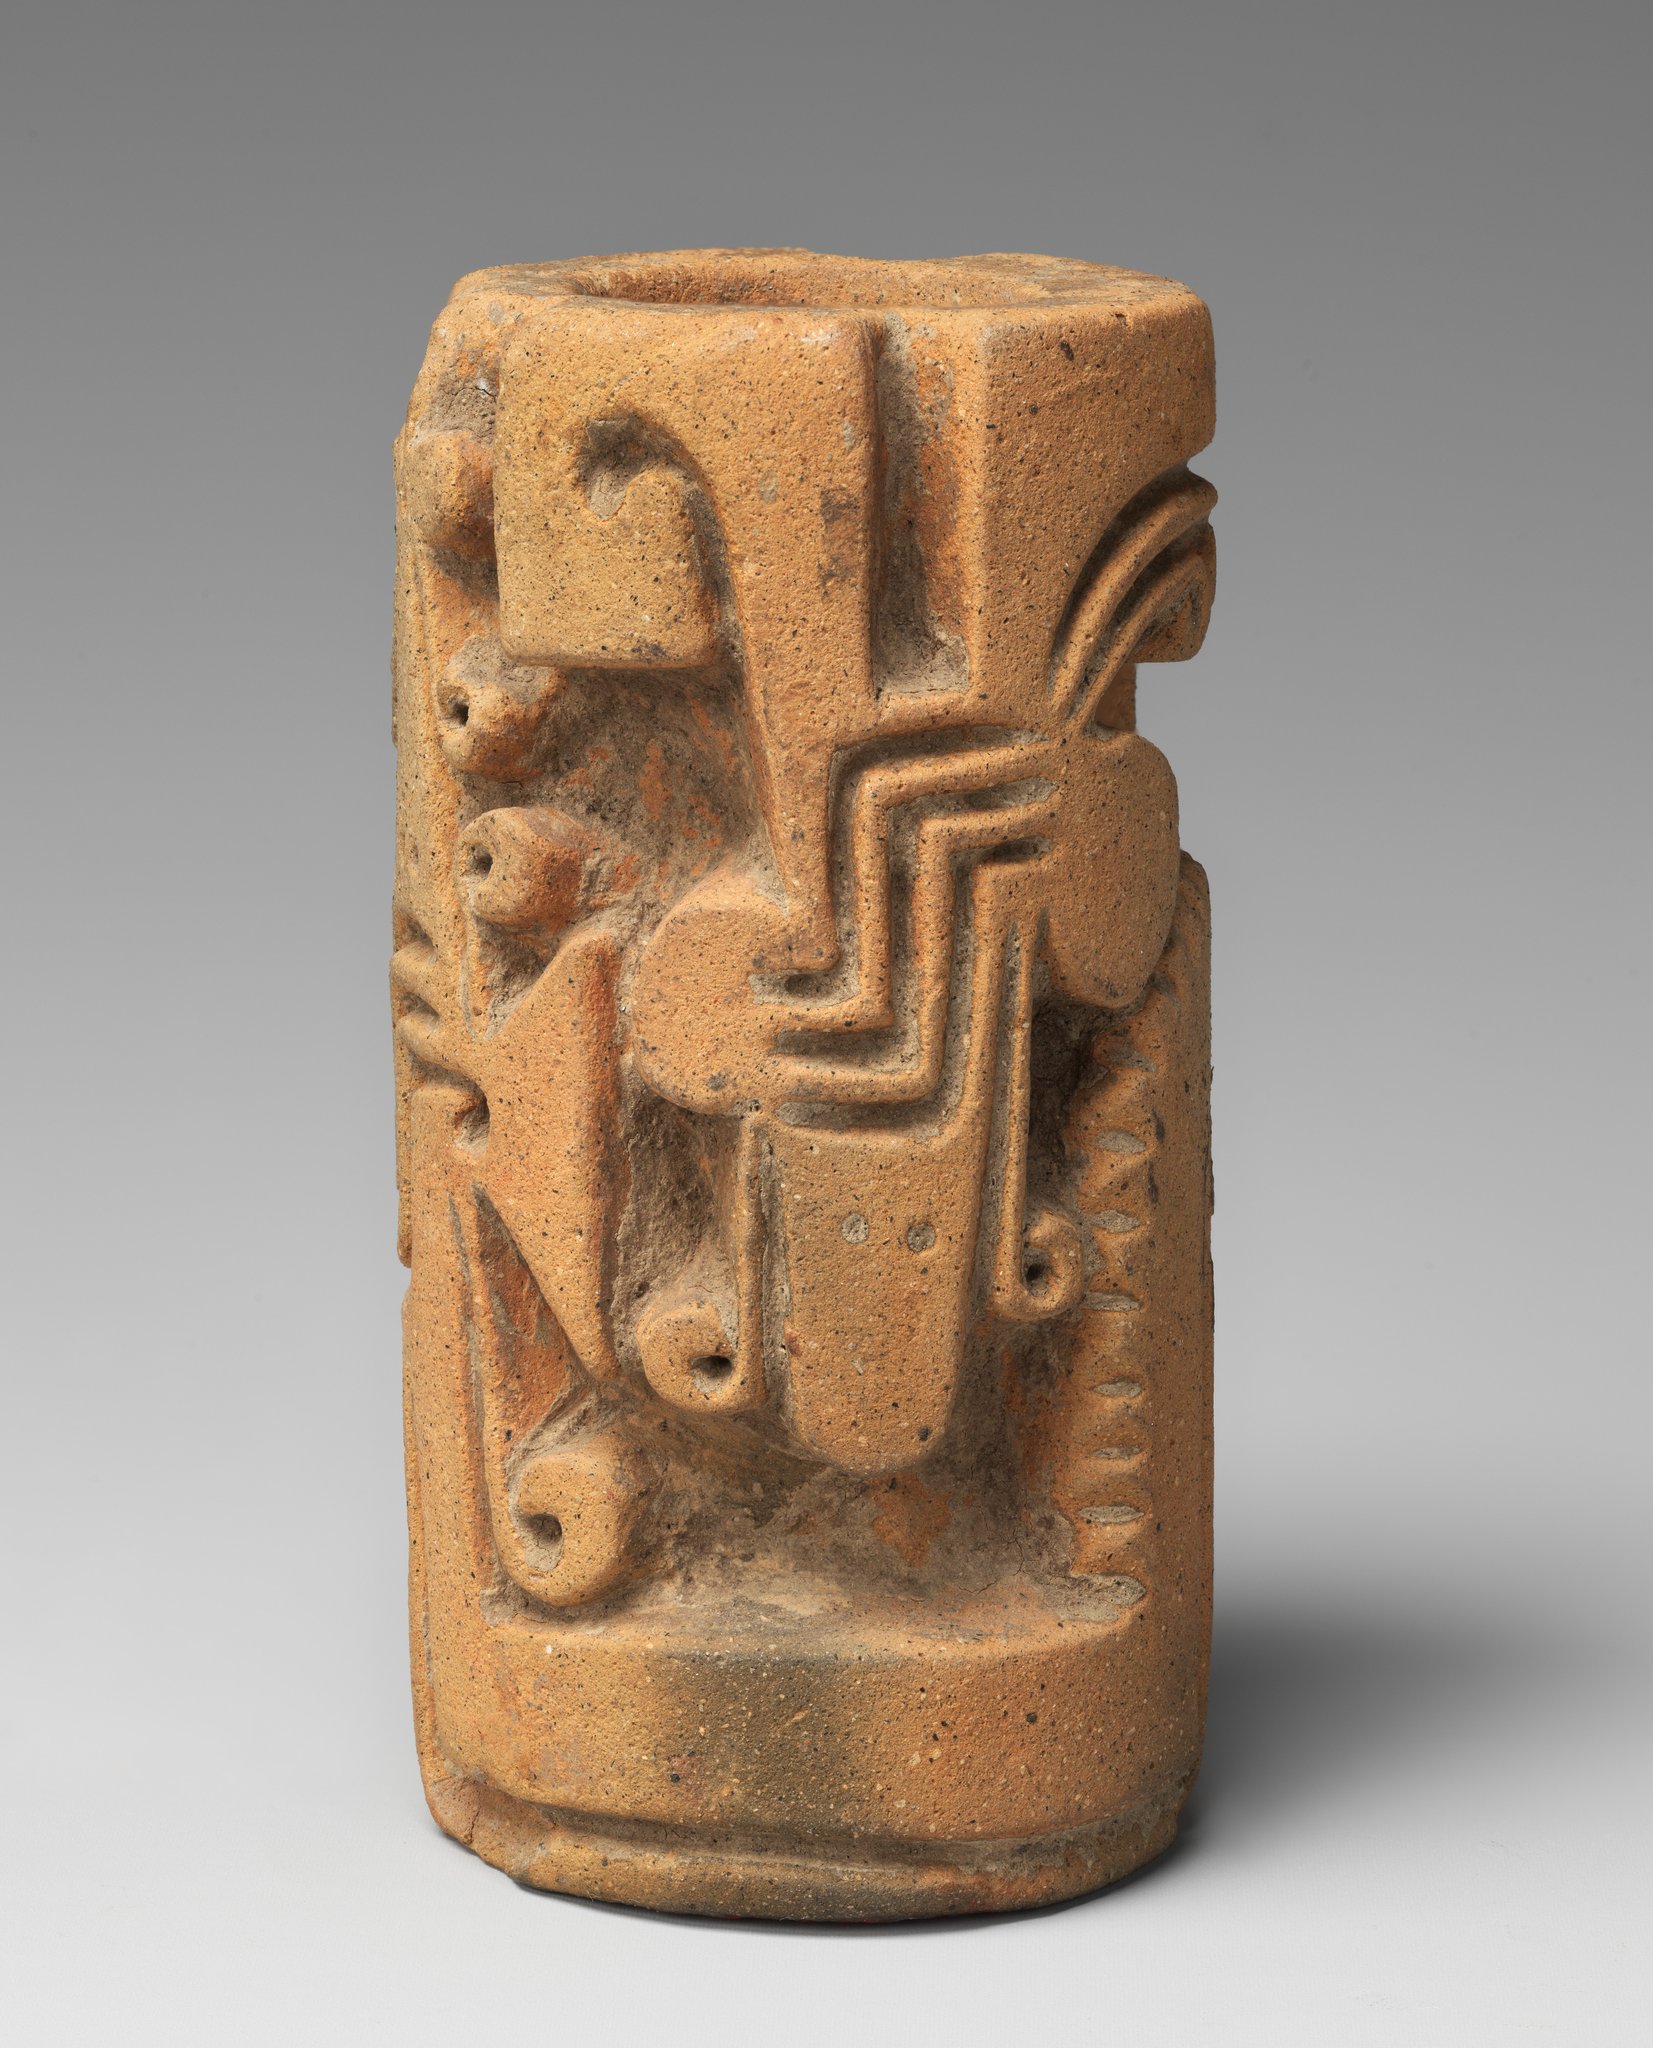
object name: stamp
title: Roller stamp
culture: manteño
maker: manteño artist(s)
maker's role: artist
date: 800-1450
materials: ceramic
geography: ecuador